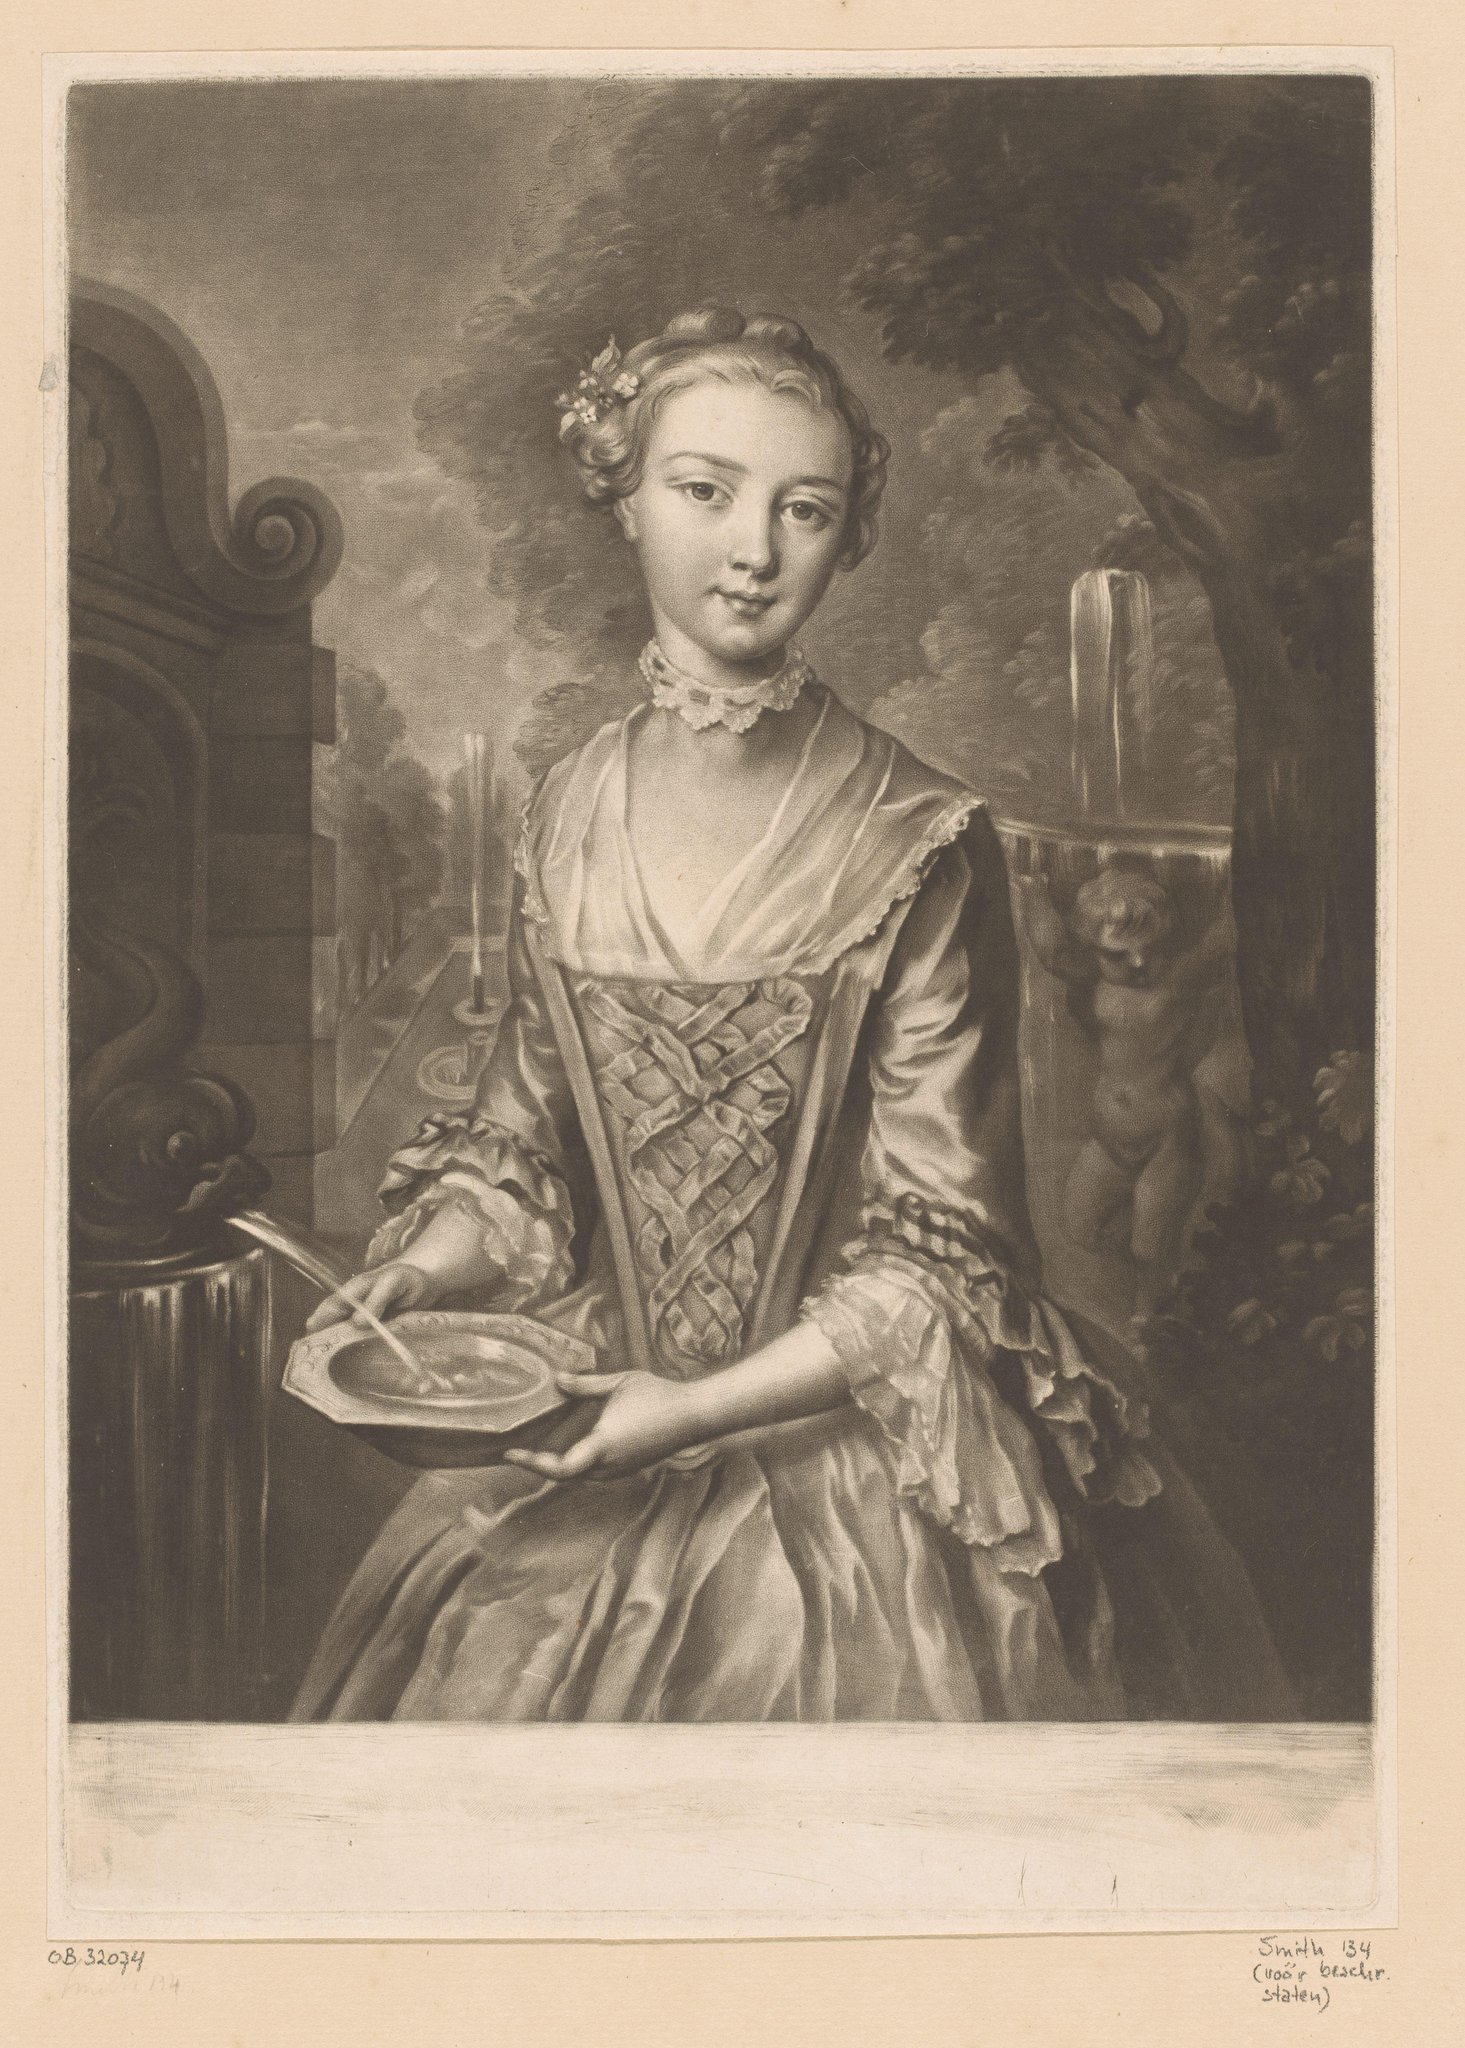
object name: print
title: Jonge vrouw bij een bron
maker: richard houston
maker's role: print maker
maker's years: 1721-1775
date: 1756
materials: paper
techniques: mezzotint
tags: well, adolescent, young woman, maiden, water (one of the four elements)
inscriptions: collector's mark: Lugt 240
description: Deze prent maakt deel uit van een serie van vier prenten.